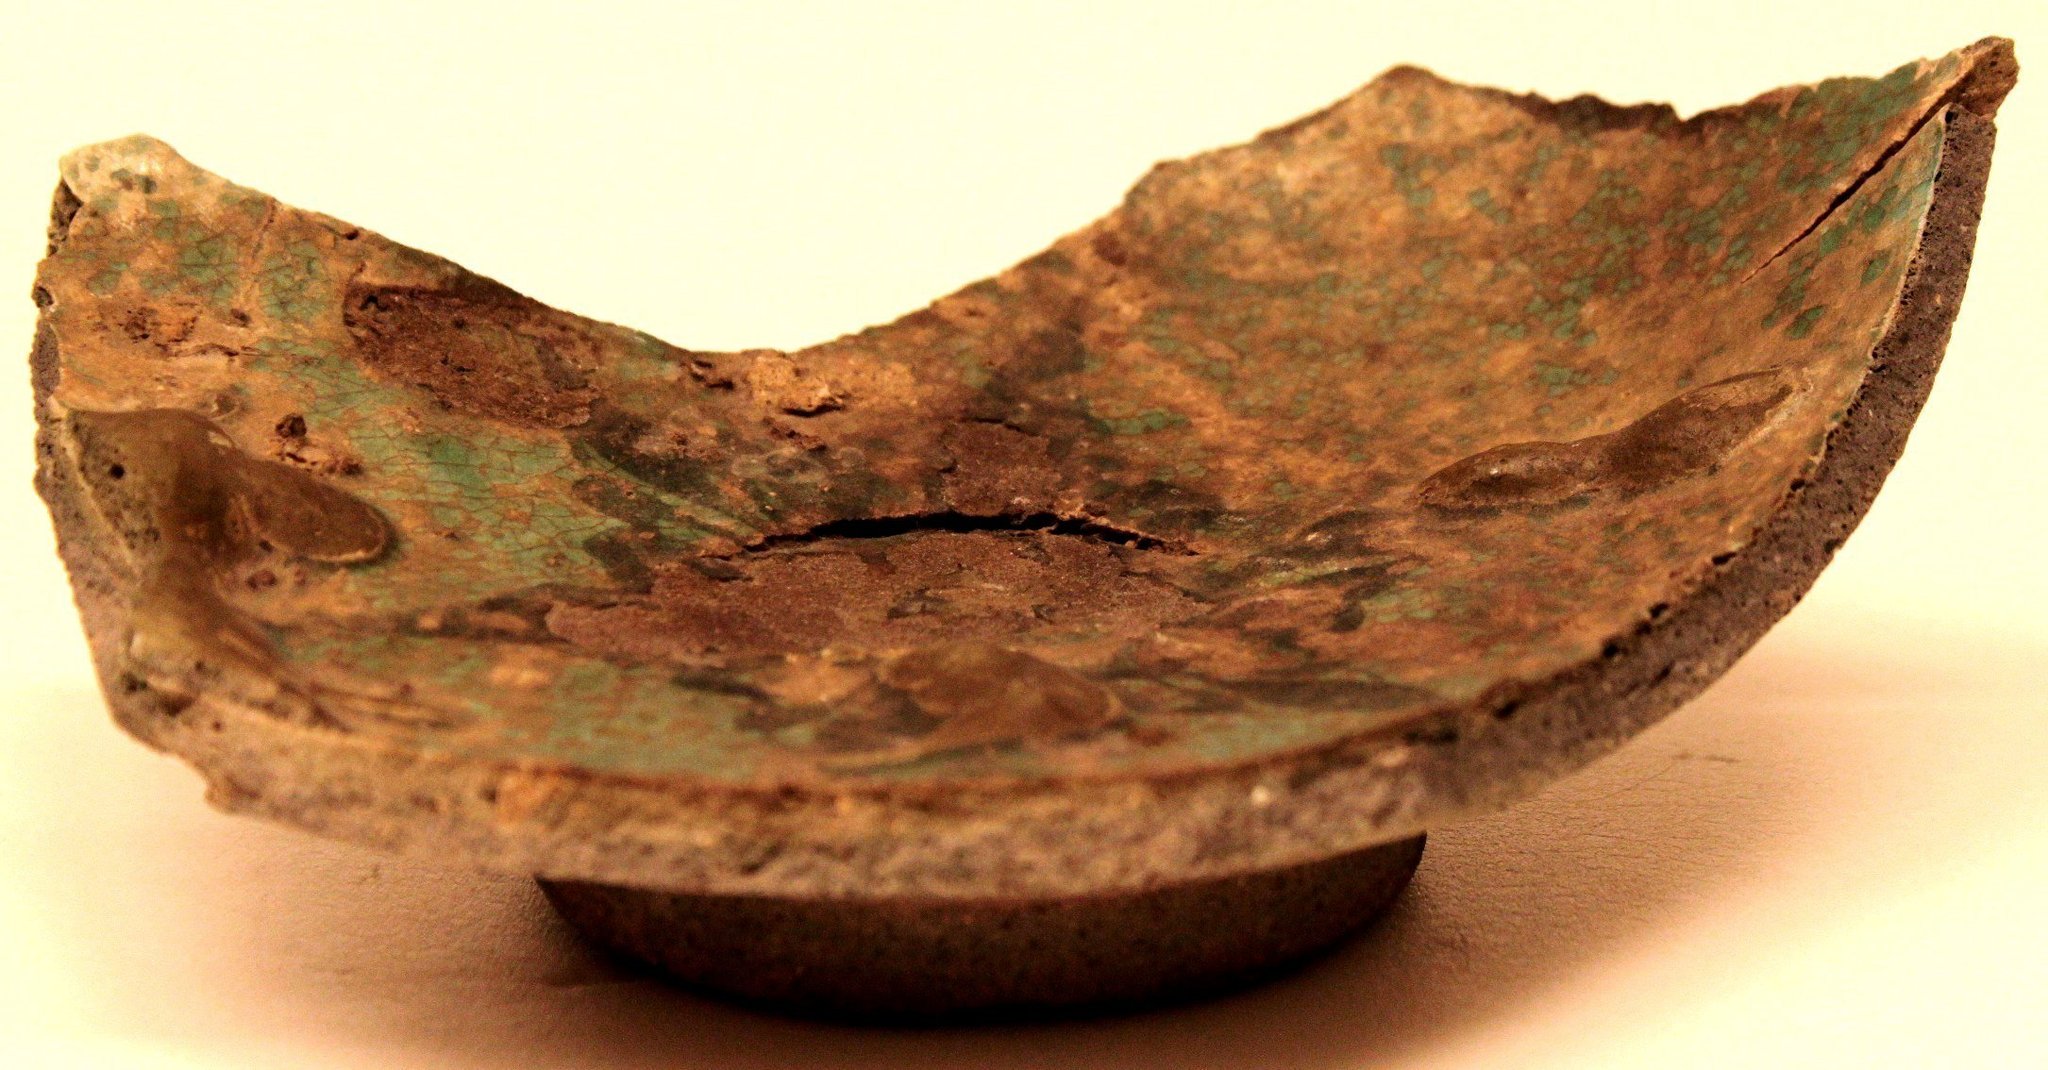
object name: waster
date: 1401-1600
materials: earthenware, glaze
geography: iran